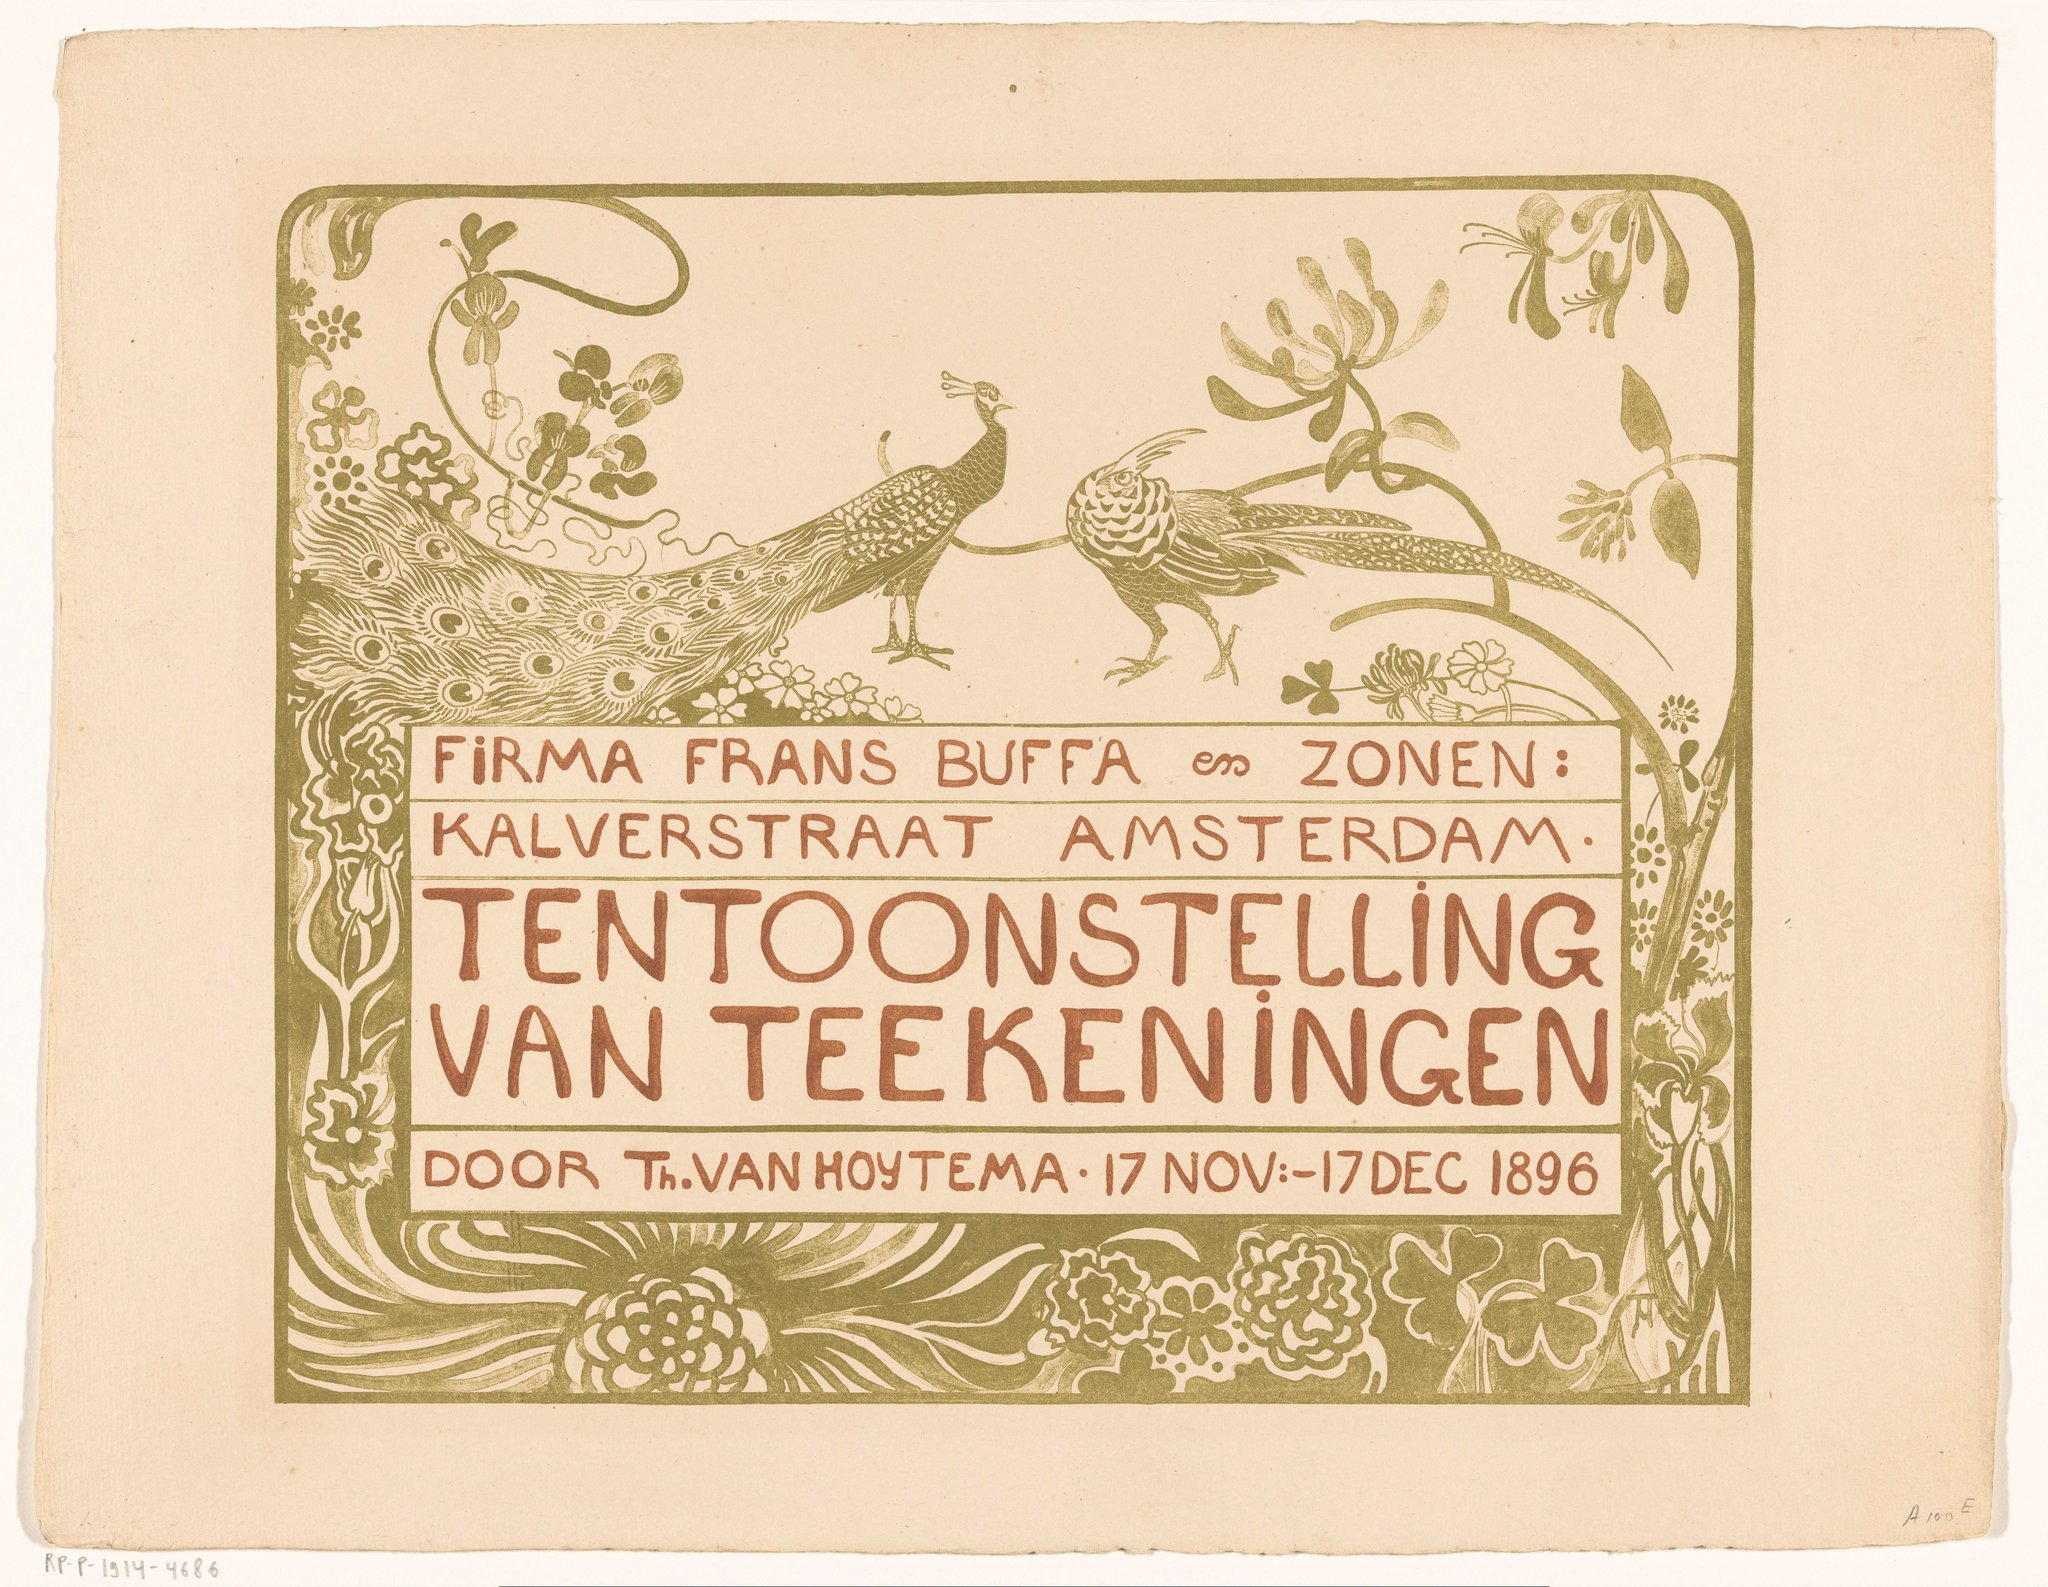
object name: print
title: Tentoonstellingsaffiche met een pauw en een fazant voor een tentoonstelling van Theo van Hoytema bij Firma Frans Buffa en Zonen te Amsterdam in 1896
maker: theo van hoytema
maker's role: draughtsman, painter, print maker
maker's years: 1863-1917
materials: paper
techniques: lithograph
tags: publisher, walker and runner birds: pheasant, ornamental birds: peacock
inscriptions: collector's mark: Lugt 2233